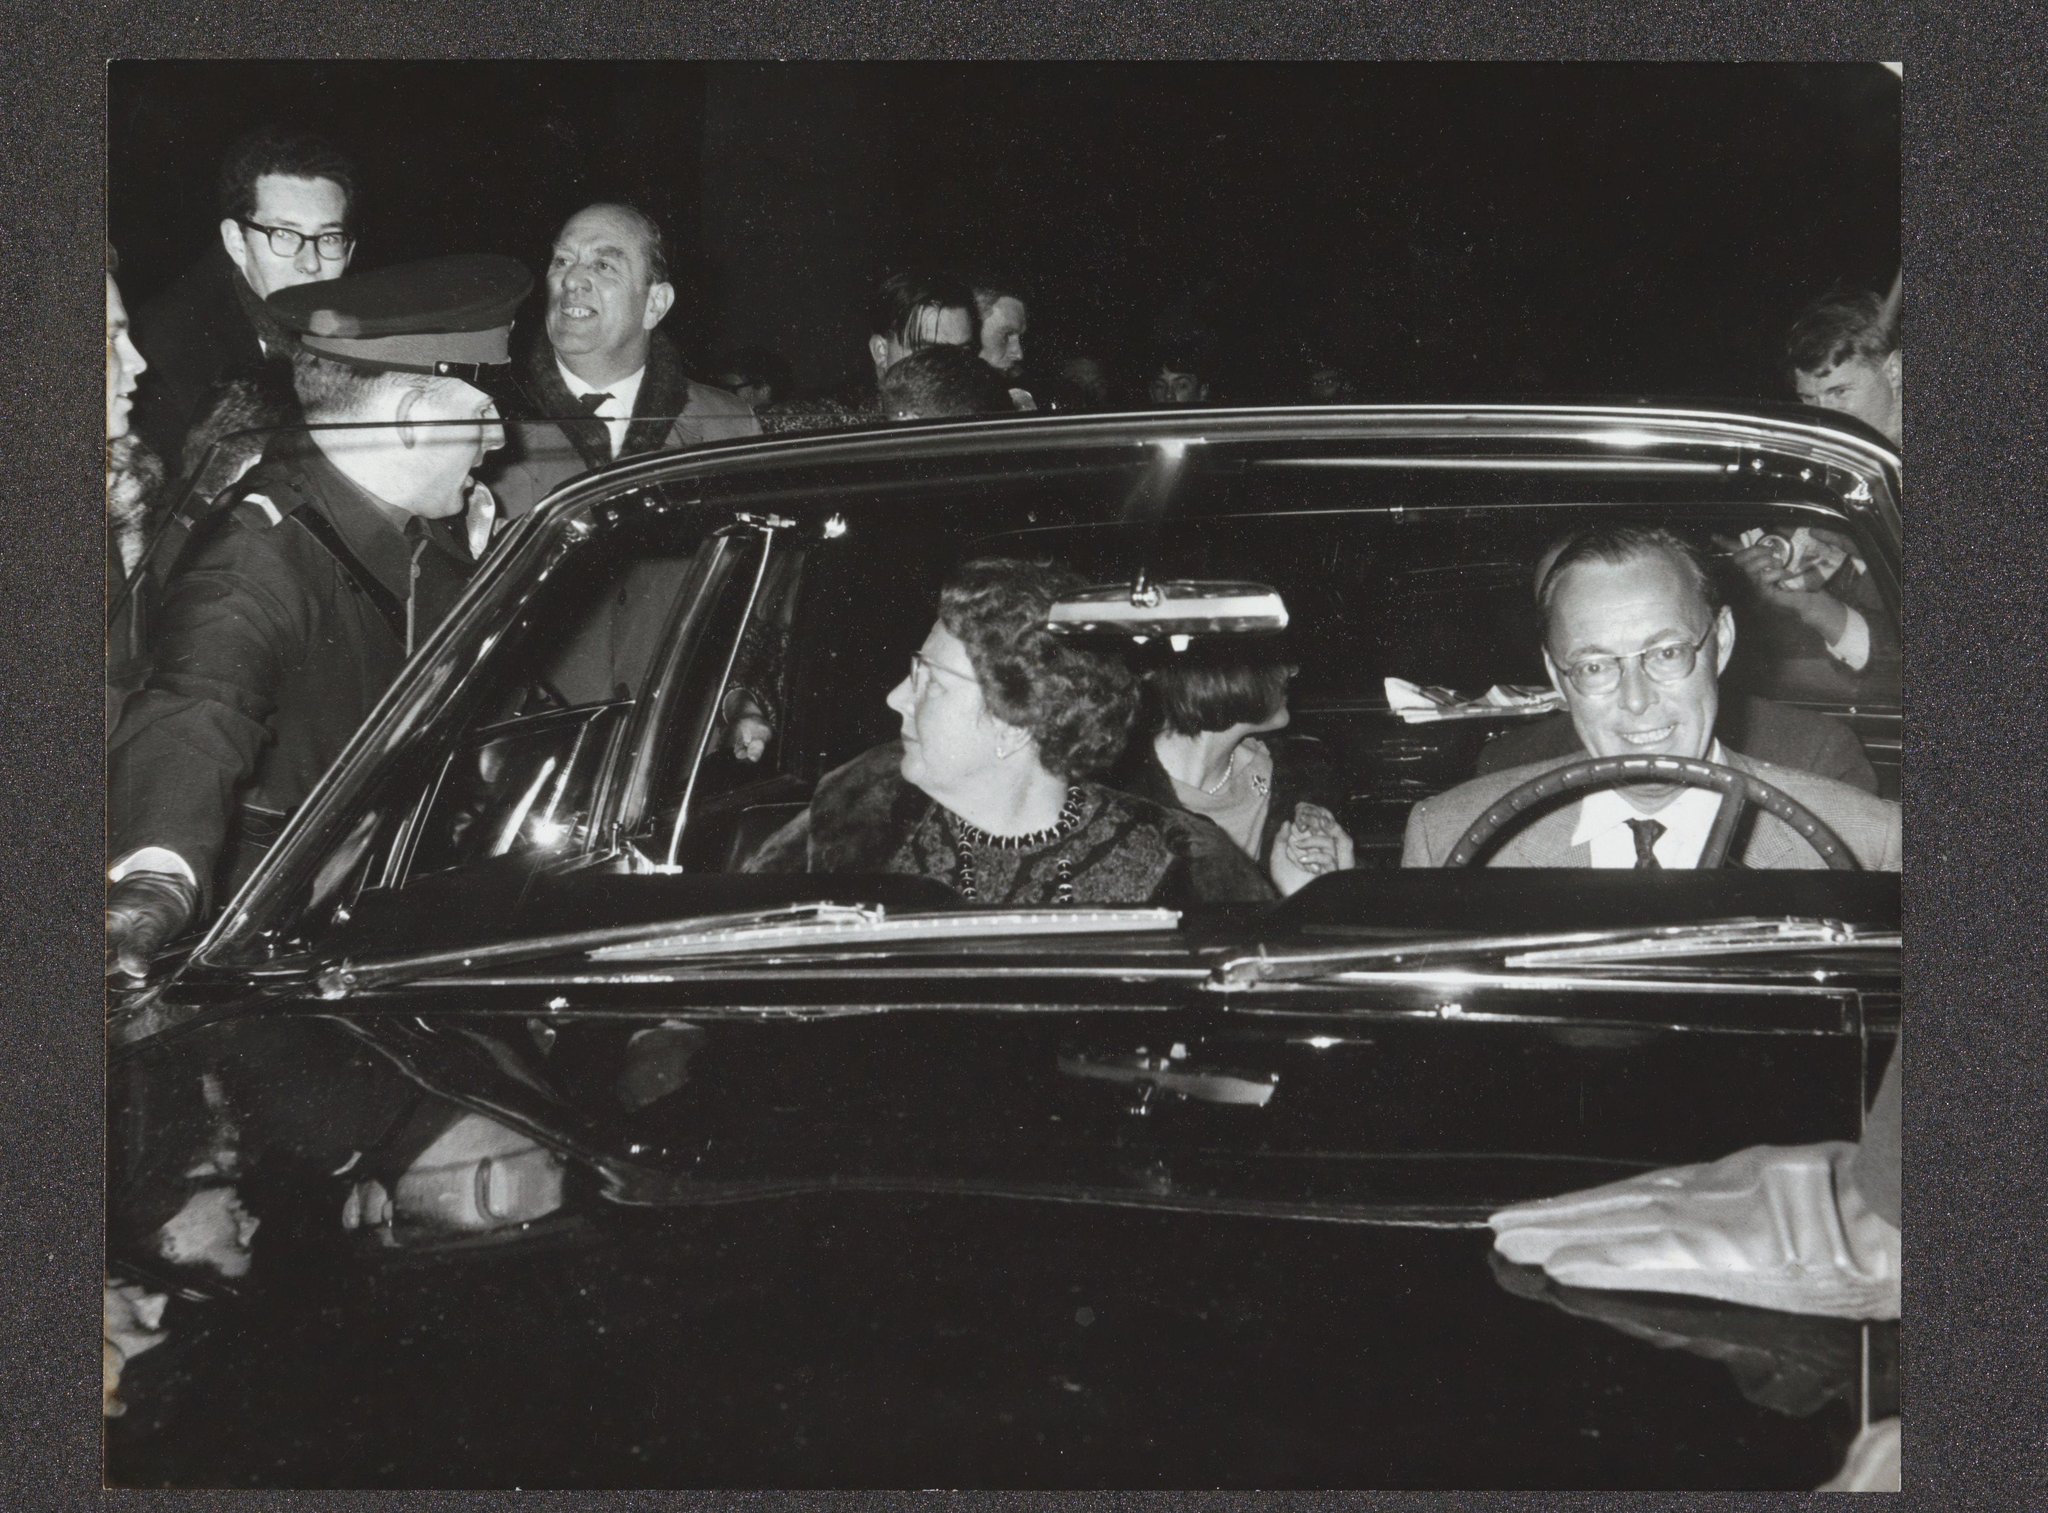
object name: photograph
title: Prinses Irene en Prins Carlos. aankomst op paleis Soestdijk zaterdagavond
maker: Anonymous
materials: photographic support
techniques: gelatin silver print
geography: netherlands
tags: utrecht, bernhard (prins der nederlanden), juliana of the netherlands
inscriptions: annotation: ‘Prinses Irene en Prins Carlos, aankomst op paleis Soestdijk zaterdagavond. foto: de marachausse had de handen vol om de auto veilig binnen de poorten van het paleis te krijgen’